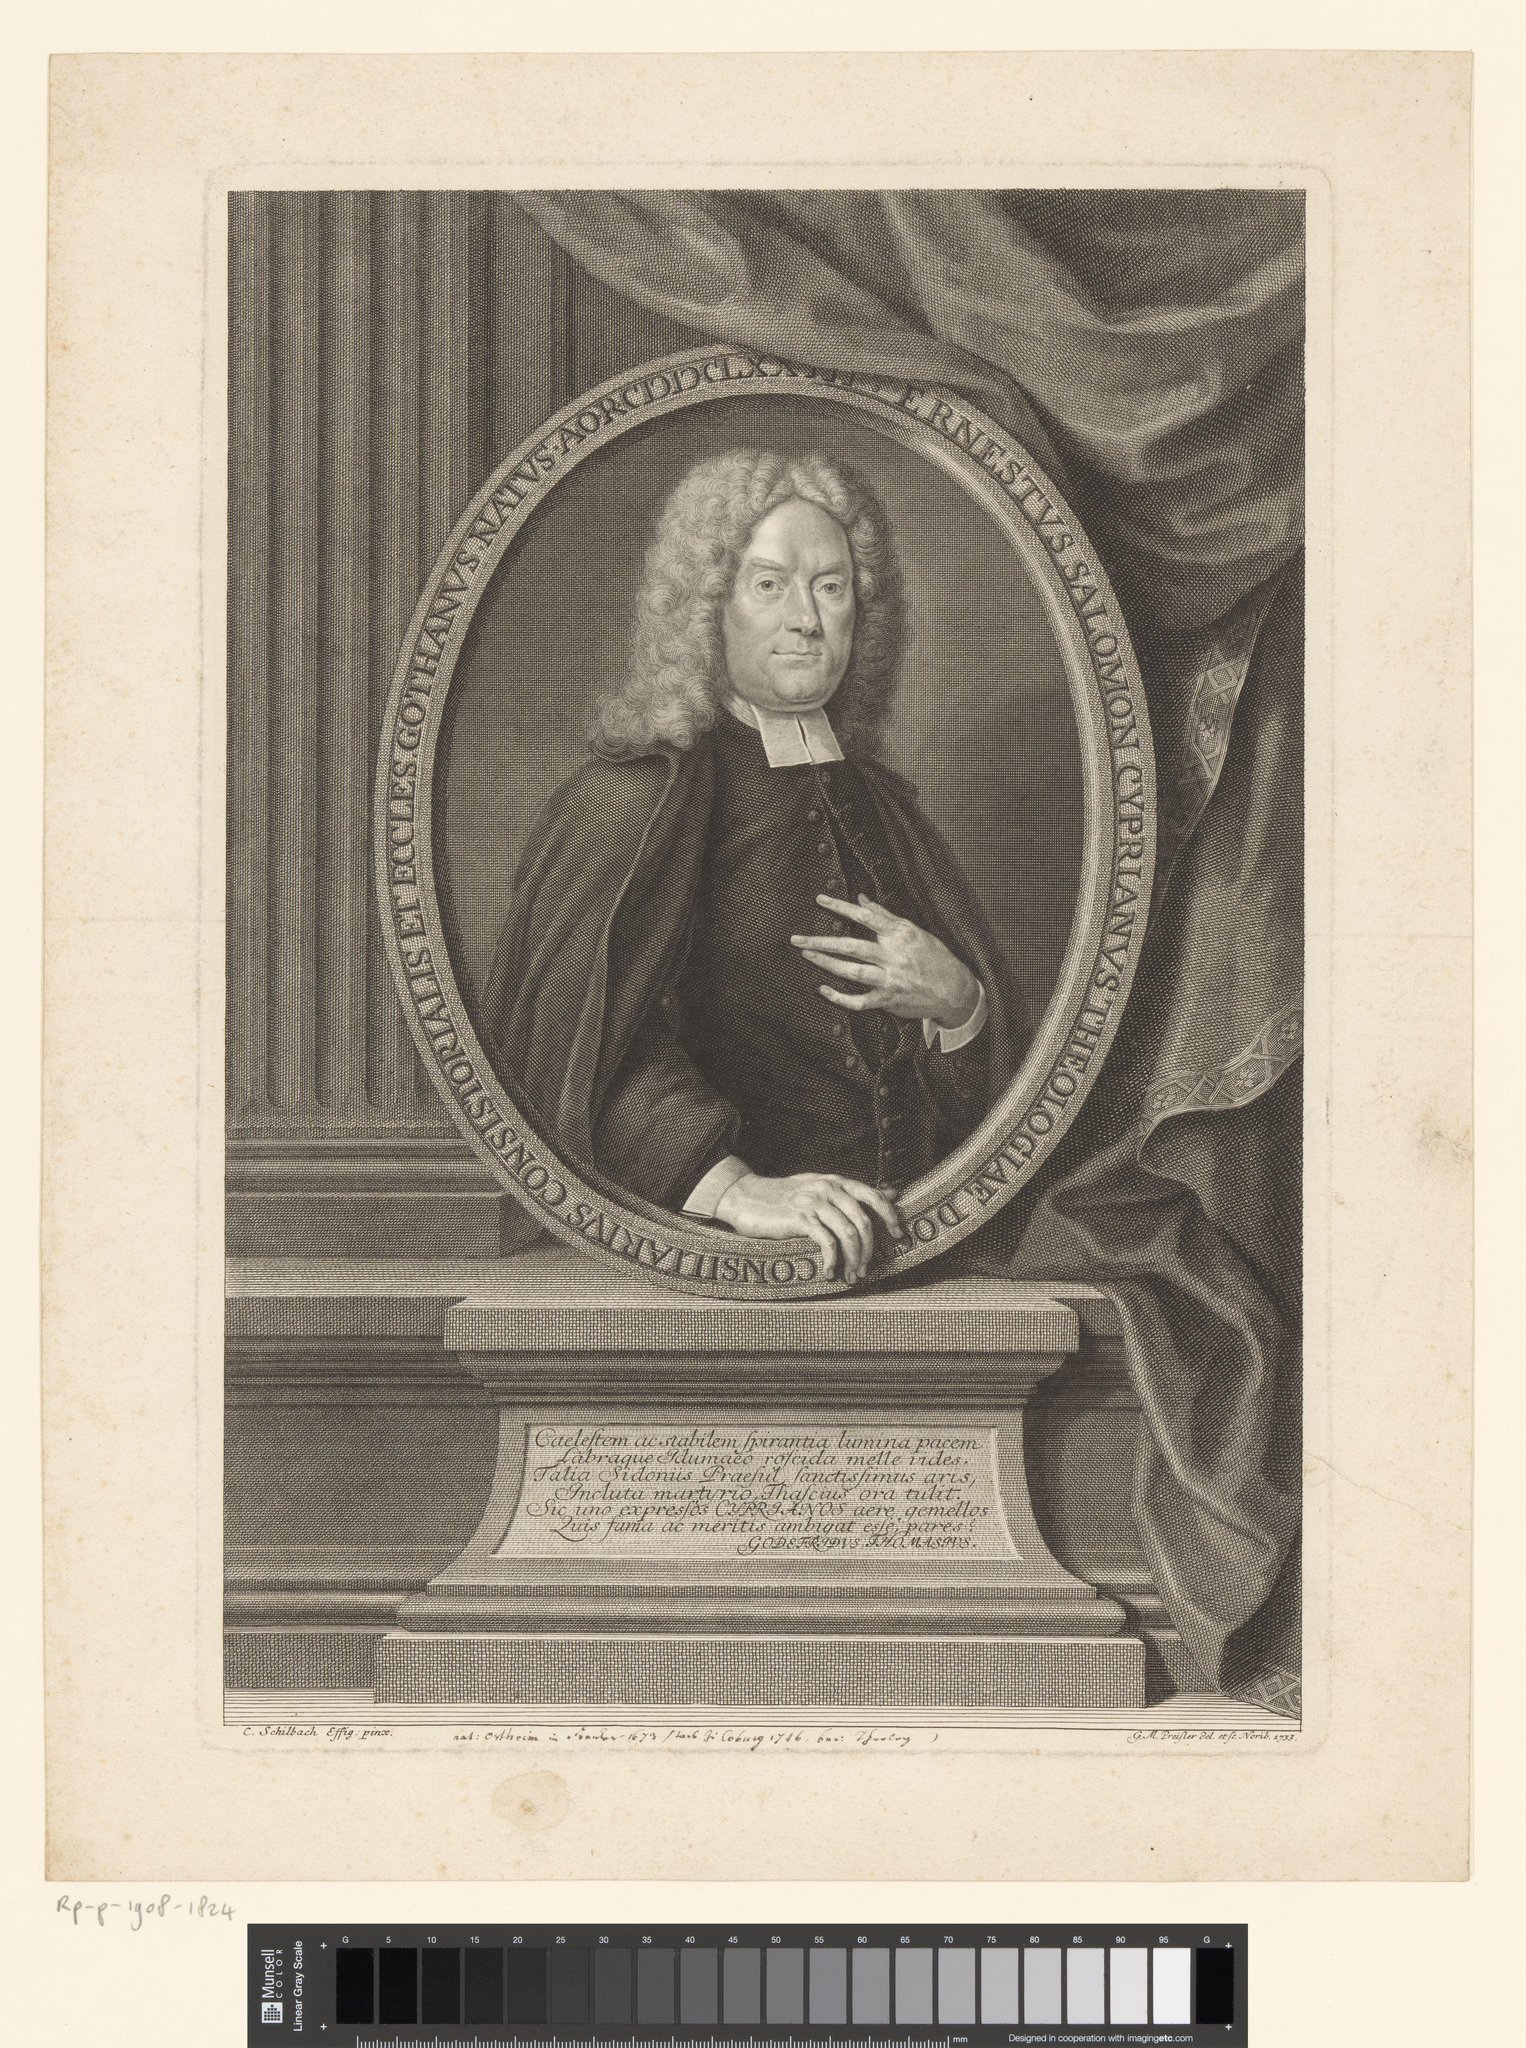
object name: print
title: Portret van Ernst Salomon Cyprianus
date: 1733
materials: paper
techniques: engraving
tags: ernst salomon cyprianus, historical persons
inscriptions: collector's mark: Lugt 2228